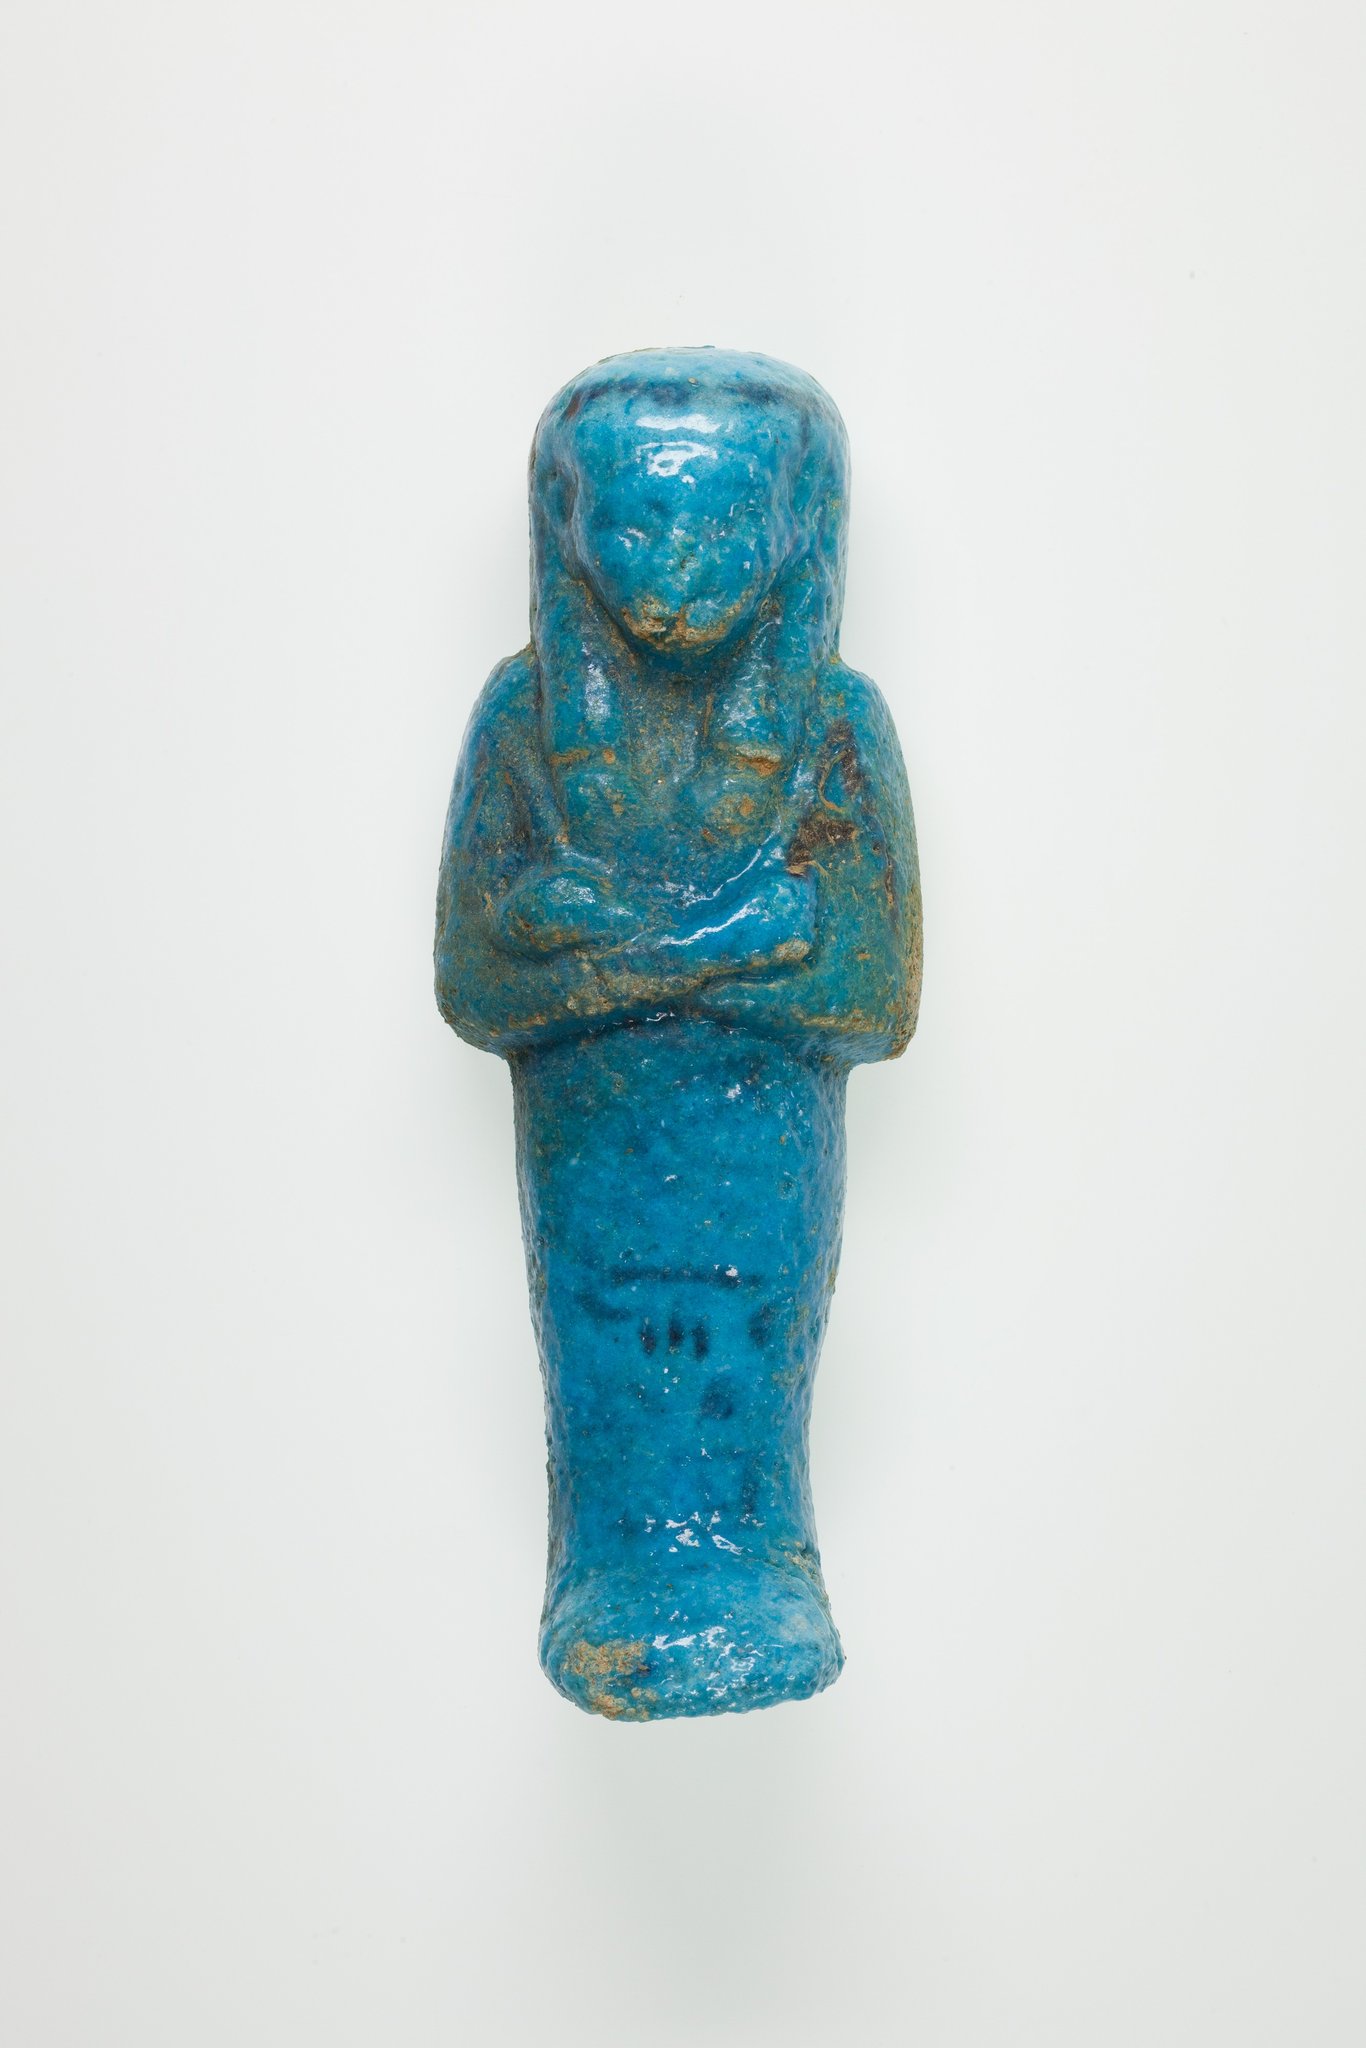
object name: shabti, henettawy c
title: Worker Shabti of Henettawy (C), Daughter of Isetemkheb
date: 990-970 BCE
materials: faience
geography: egypt